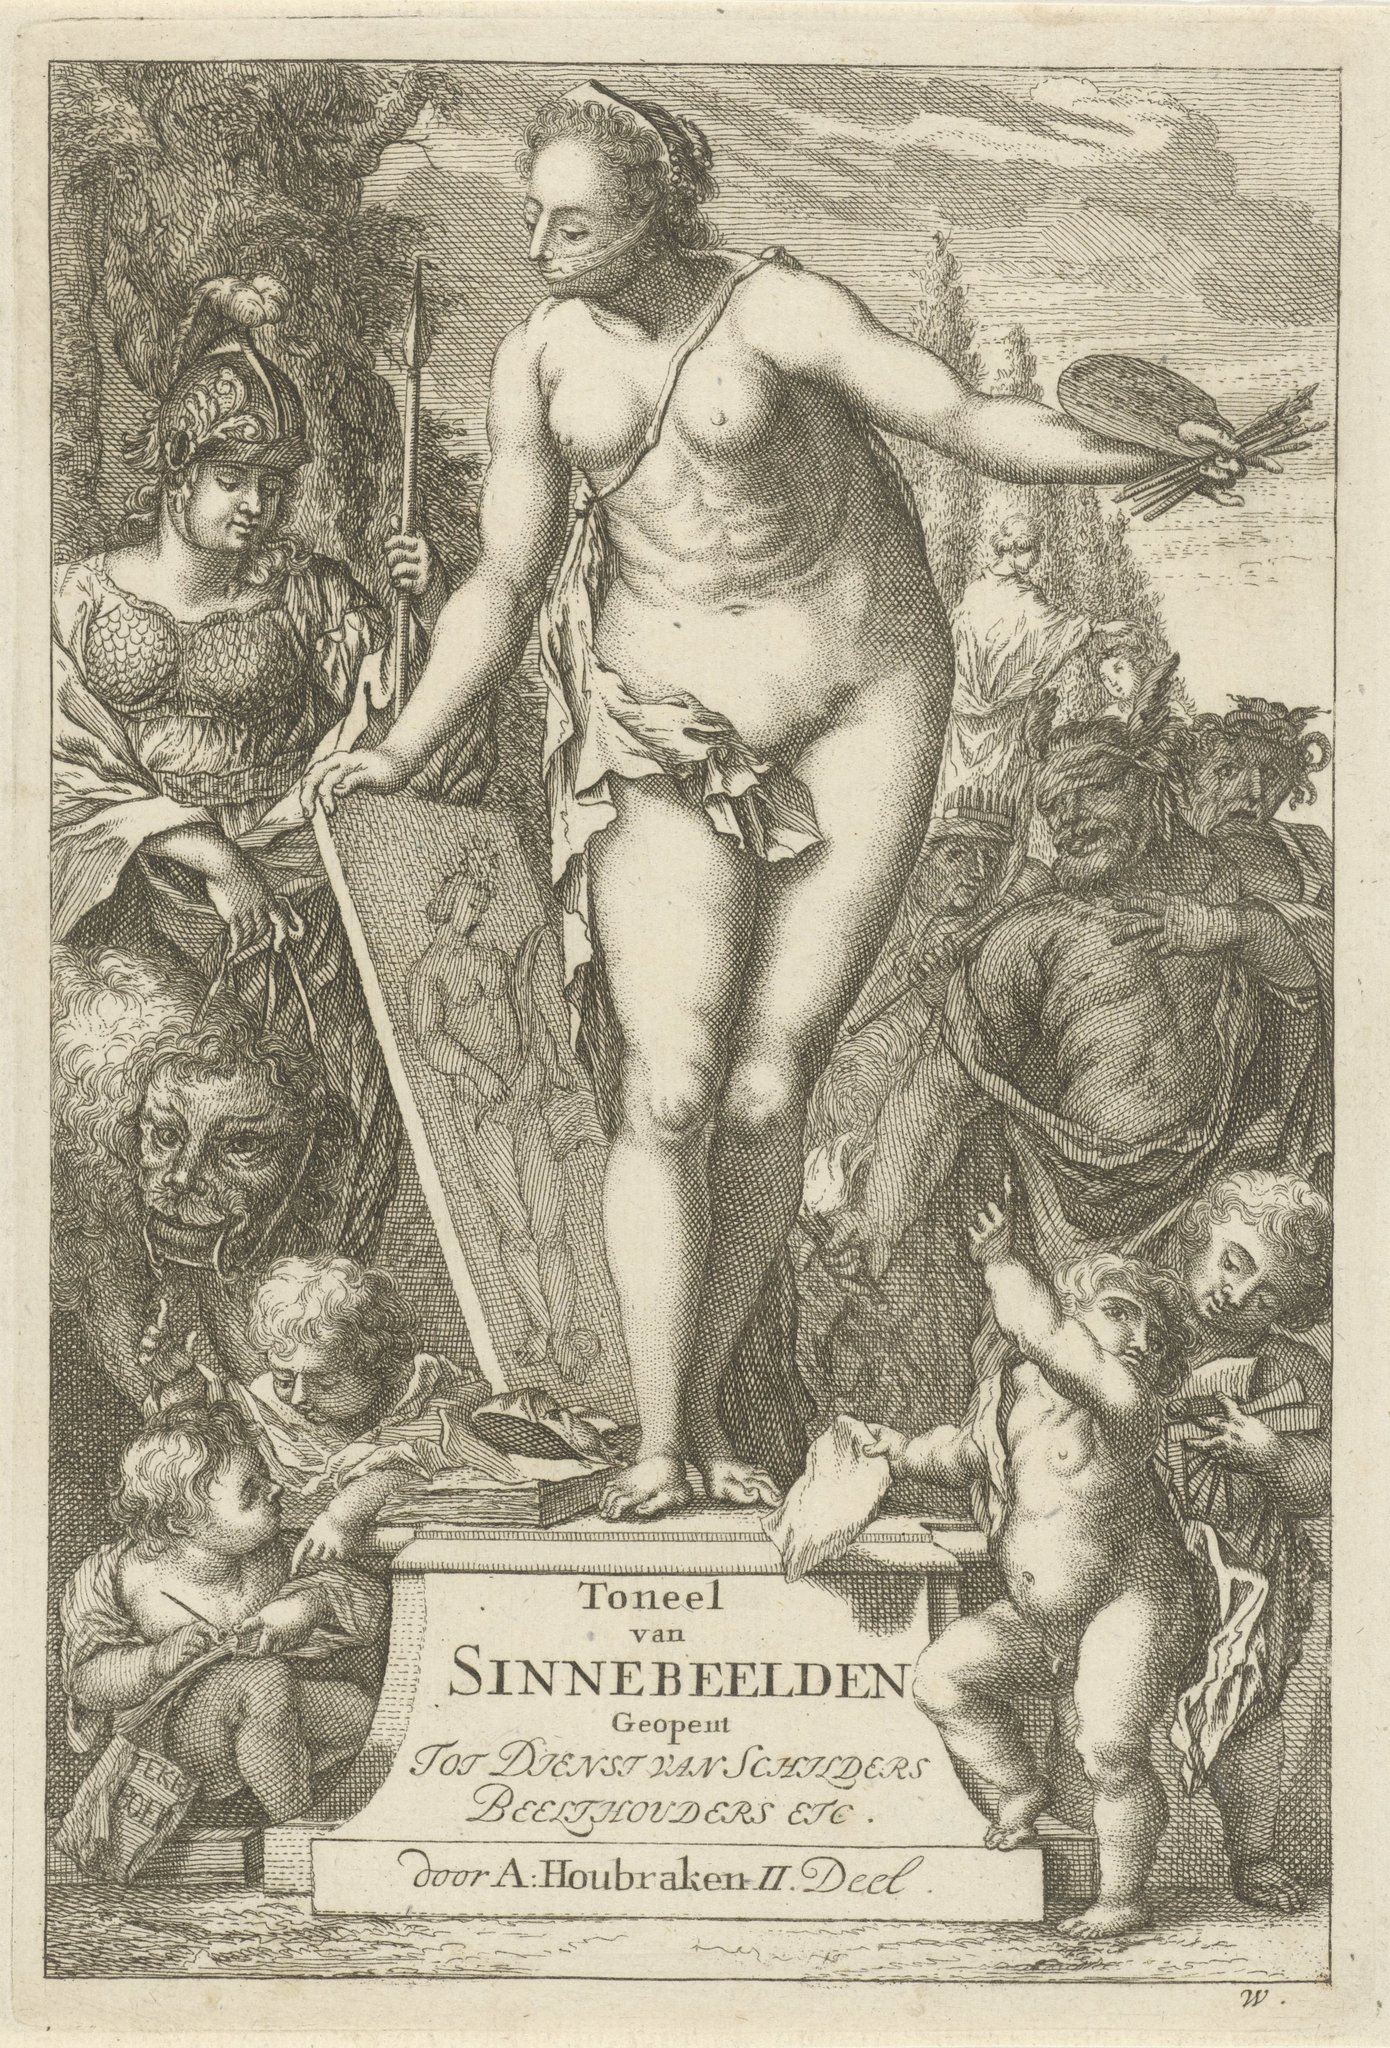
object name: print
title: Toneel van sinnebeelden geopent tot dienst van schilders beelthouders etc.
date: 1688-1700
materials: paper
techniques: engraving, etching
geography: dordrecht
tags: 'pictura', symbolic representations, allegories and emblems ~ painting; 'pittura' (ripa), envy; 'invidia' (ripa) ~ personification of one of the seven deadly sins, ignorance; 'ignoranza', 'ignoranza di tutte le cose', 'ignoranza in un ricco senza lettere' (ripa), cupids: 'amores', 'amoretti', 'putti', reason; 'ragione' (ripa) (+ abstract concept represented by female figure)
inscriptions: collector's mark: Lugt 2228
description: De gepersonifieerde Schilderkunst staat op een piëdestal waarop de serietitel in zes regels in het Nederlands. Zij kan niet spreken door de doek die voor haar mond is gebonden, zodat men moet zien wat zij uitbeeldt. Achter haar staat de Onwetendheid met ezelsoren, die blindelings de Schilderkunst beschimpt. Achter Onwetendheid de Afgunst. De Schilderkunst toont echter haar werk aan de gepersonifieerde Rede. Vier putti omringen de sokkel. Titelprent van deel 2 van een serie prenten met zinnebeelden, in totaal bestaande uit drie delen met respectievelijk 23, 17 en 20 prenten.